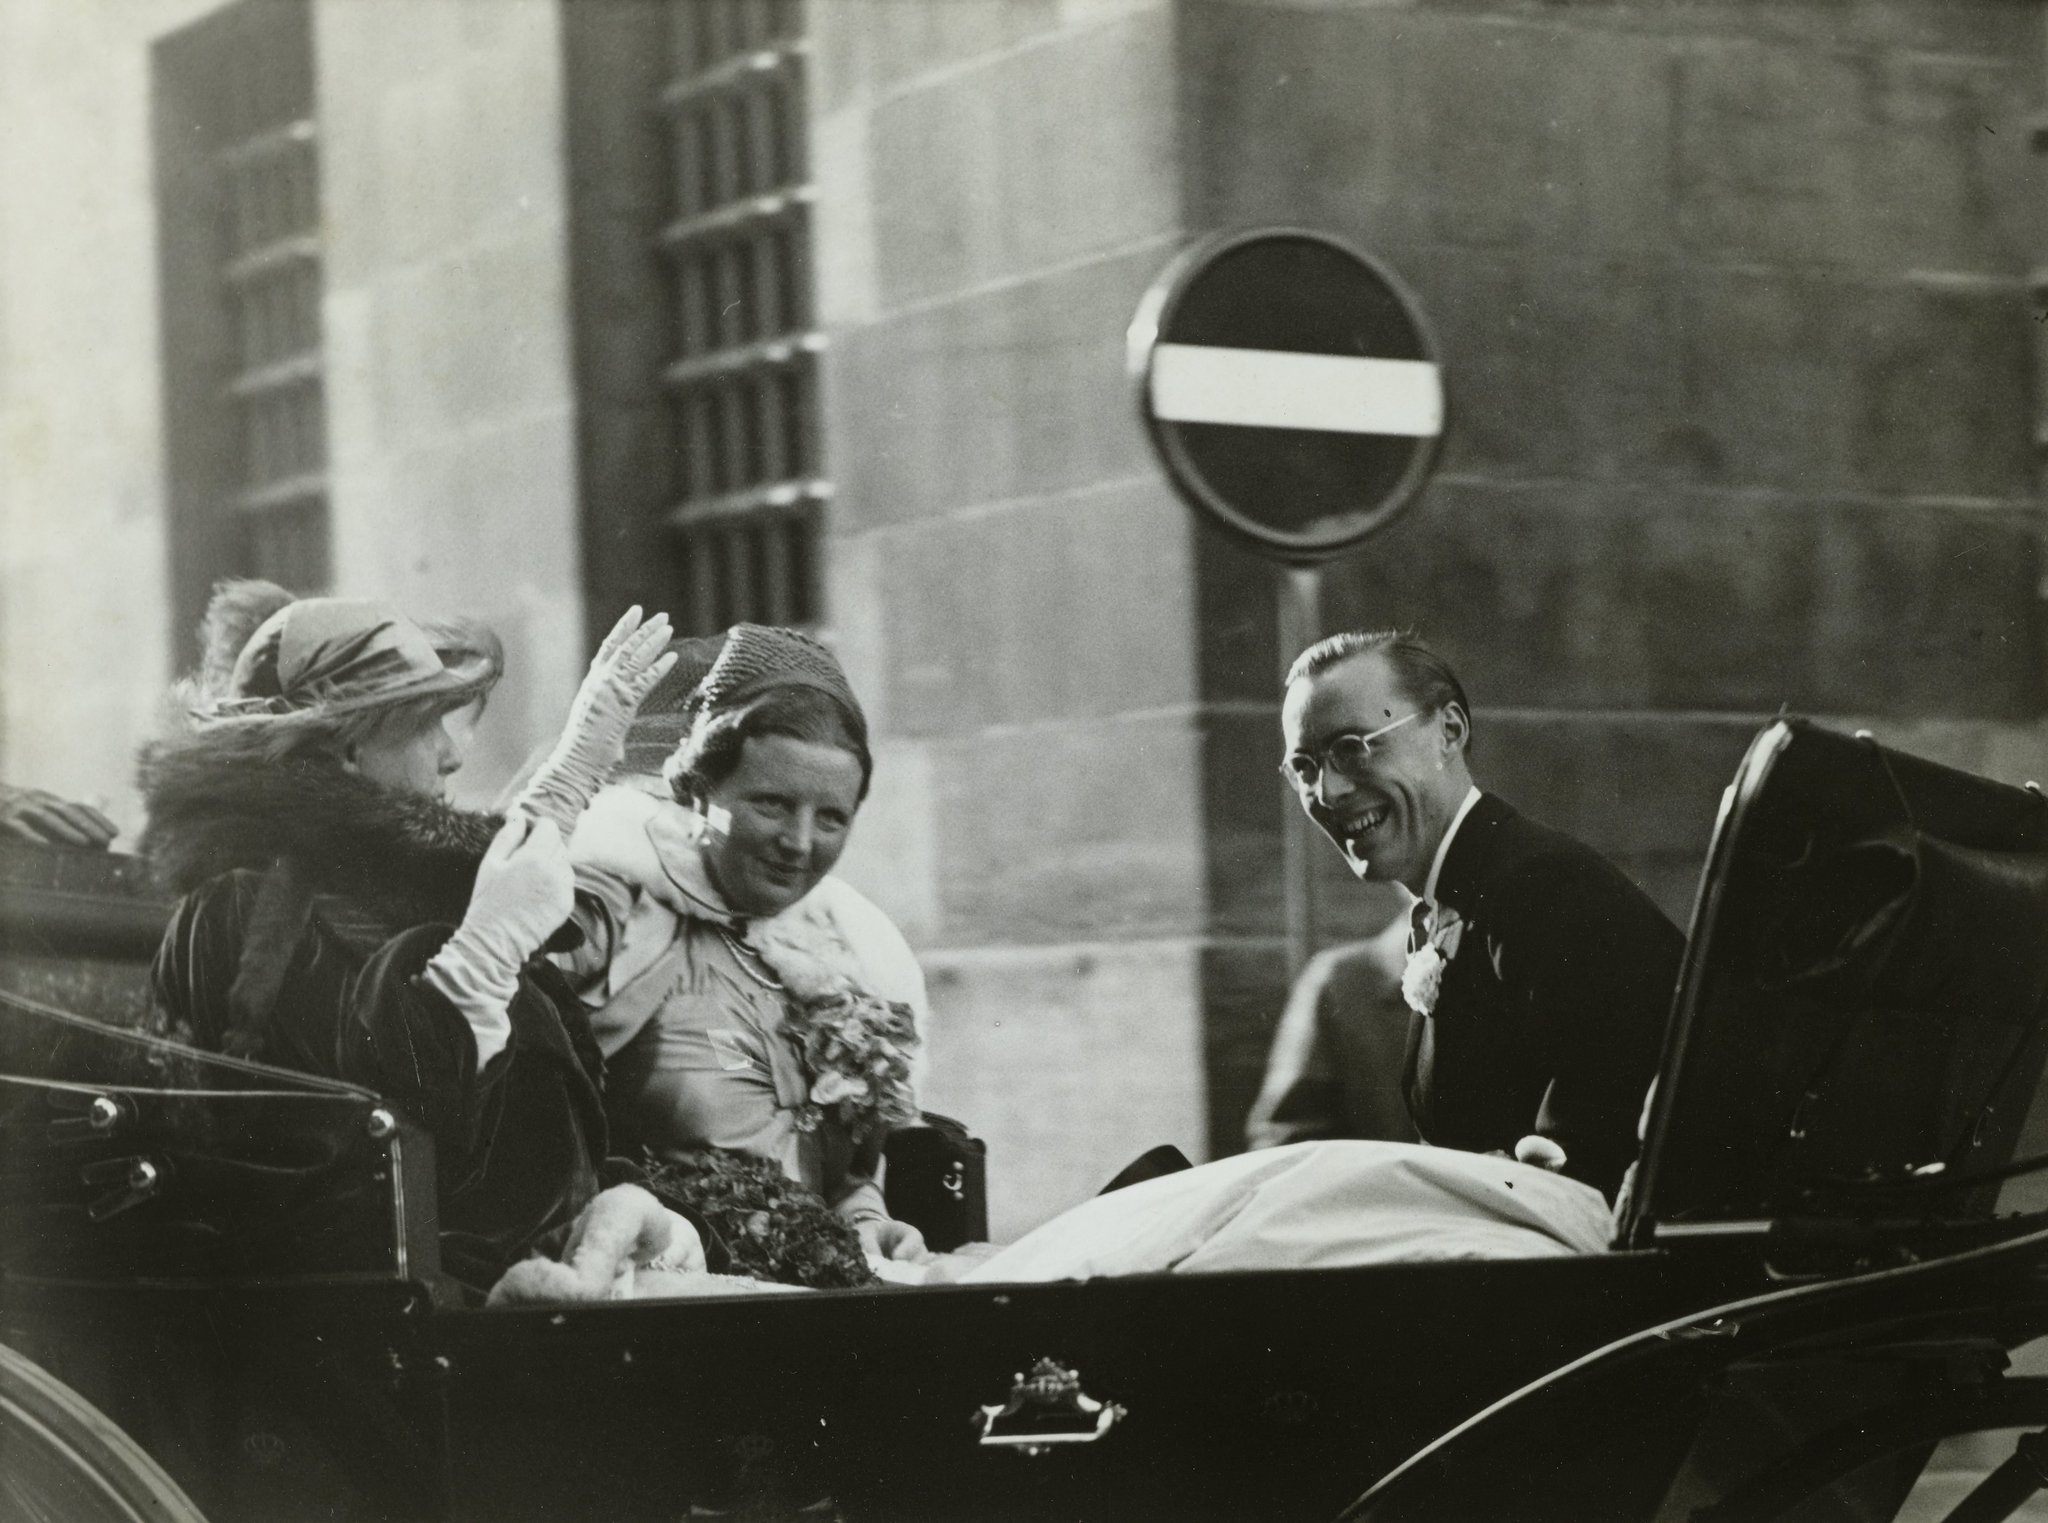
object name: photograph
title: Koningin Wilhelmina, prinses Juliana en prins Bernhard in een rijtuig voor het paleis op de Dam in Amsterdam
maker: sem presser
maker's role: fotograaf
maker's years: 1917-1986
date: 1936-1938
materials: photographic support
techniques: gelatin silver print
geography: amsterdam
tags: the hague, print maker, wilhelmina of the netherlands, utrecht, bernhard (prins der nederlanden), juliana of the netherlands, four-wheeled, animal-drawn vehicle, e.g.: cab, carriage, coach, ruler, sovereign - bb - female ruler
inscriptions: stamp: ‘copyright algemeen nederlands fotopersbureau Paleisstraat 17 Amsterdam-c’